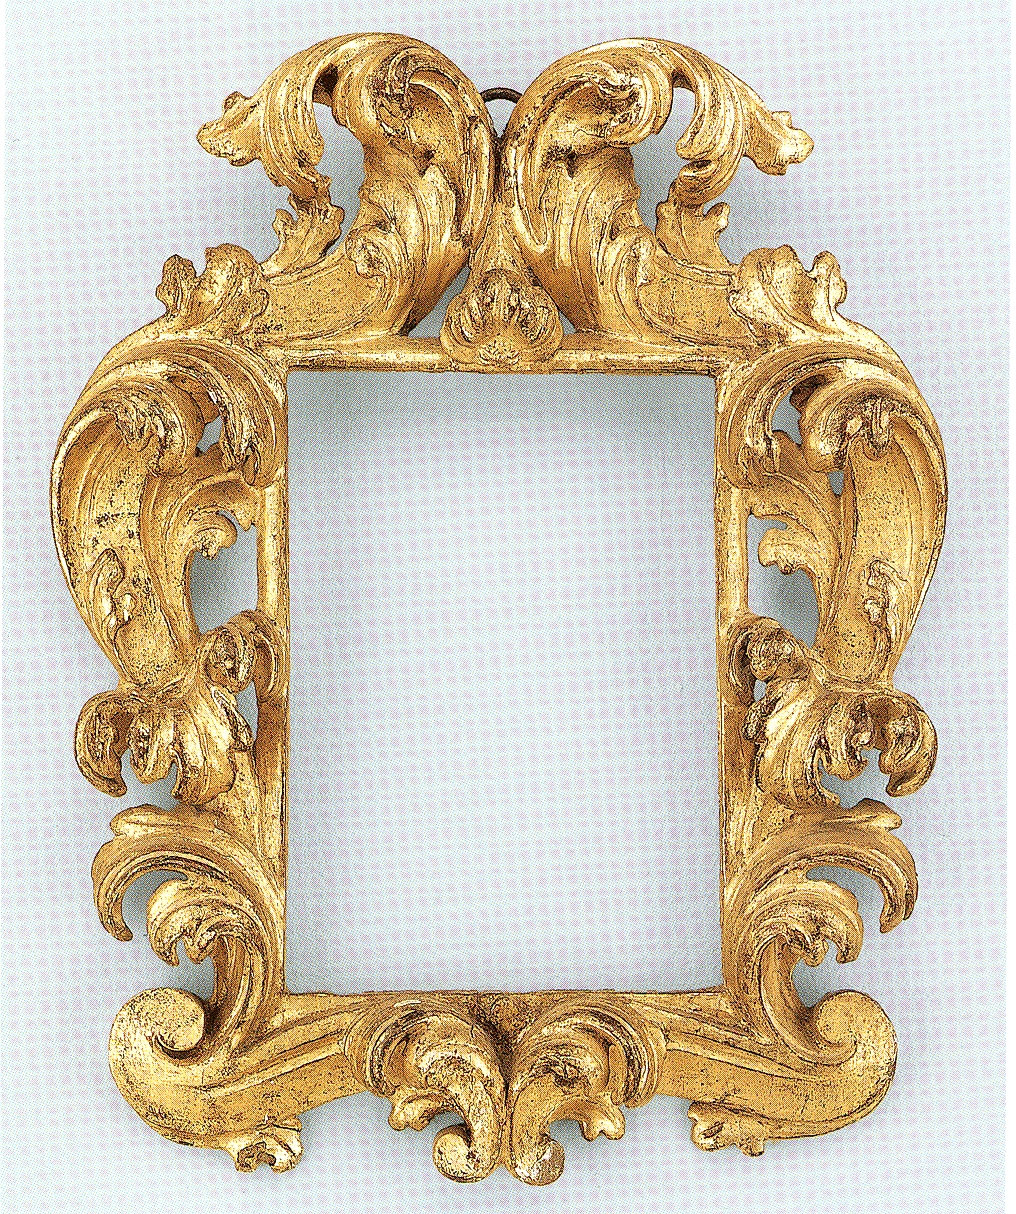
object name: frame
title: Cauliculi frame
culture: italian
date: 1801-1900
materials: wood